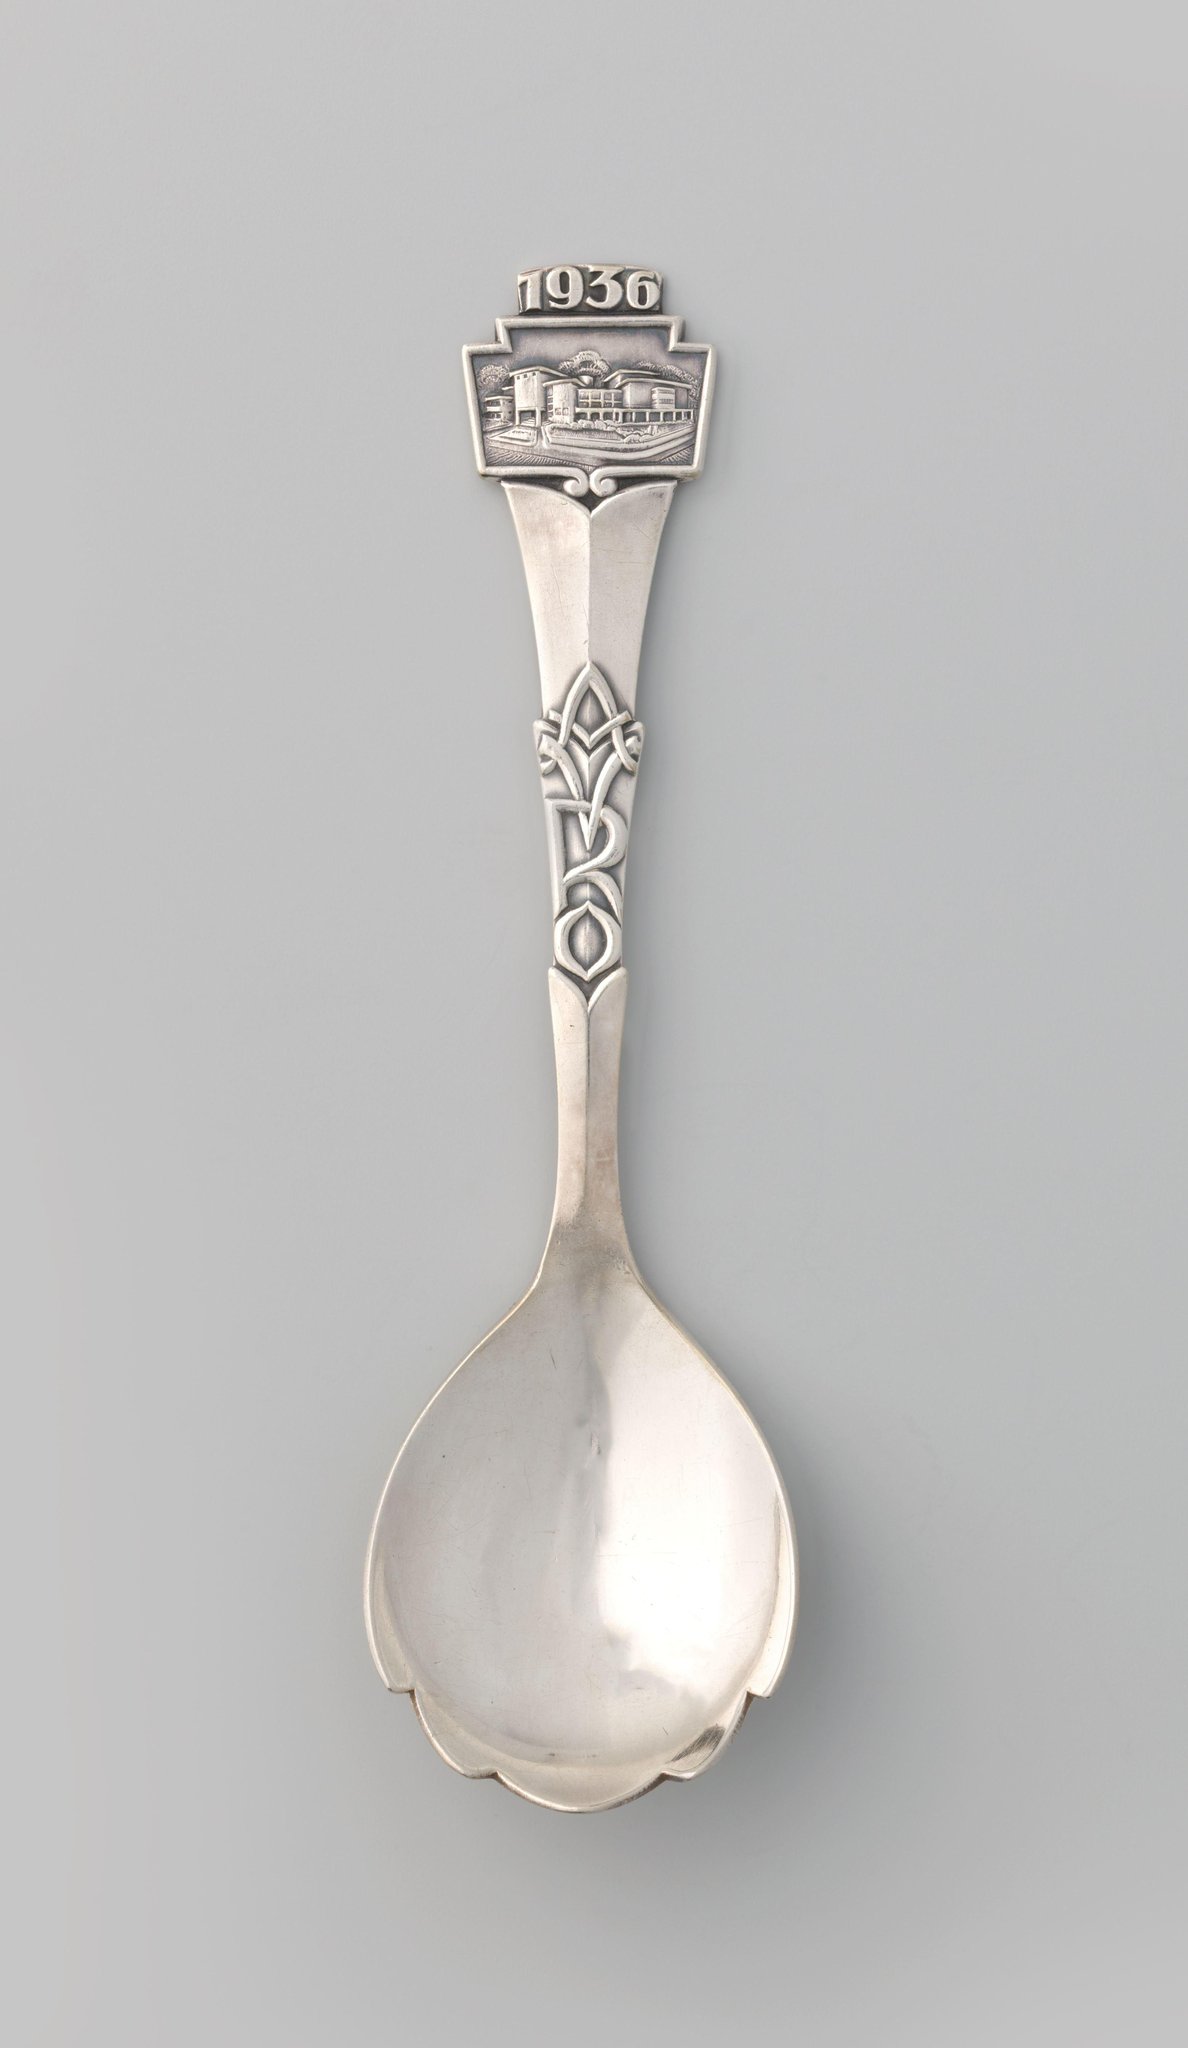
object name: suikerschep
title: Suikerlepel AVRO, 1936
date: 1936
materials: metal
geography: zeist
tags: netherlands